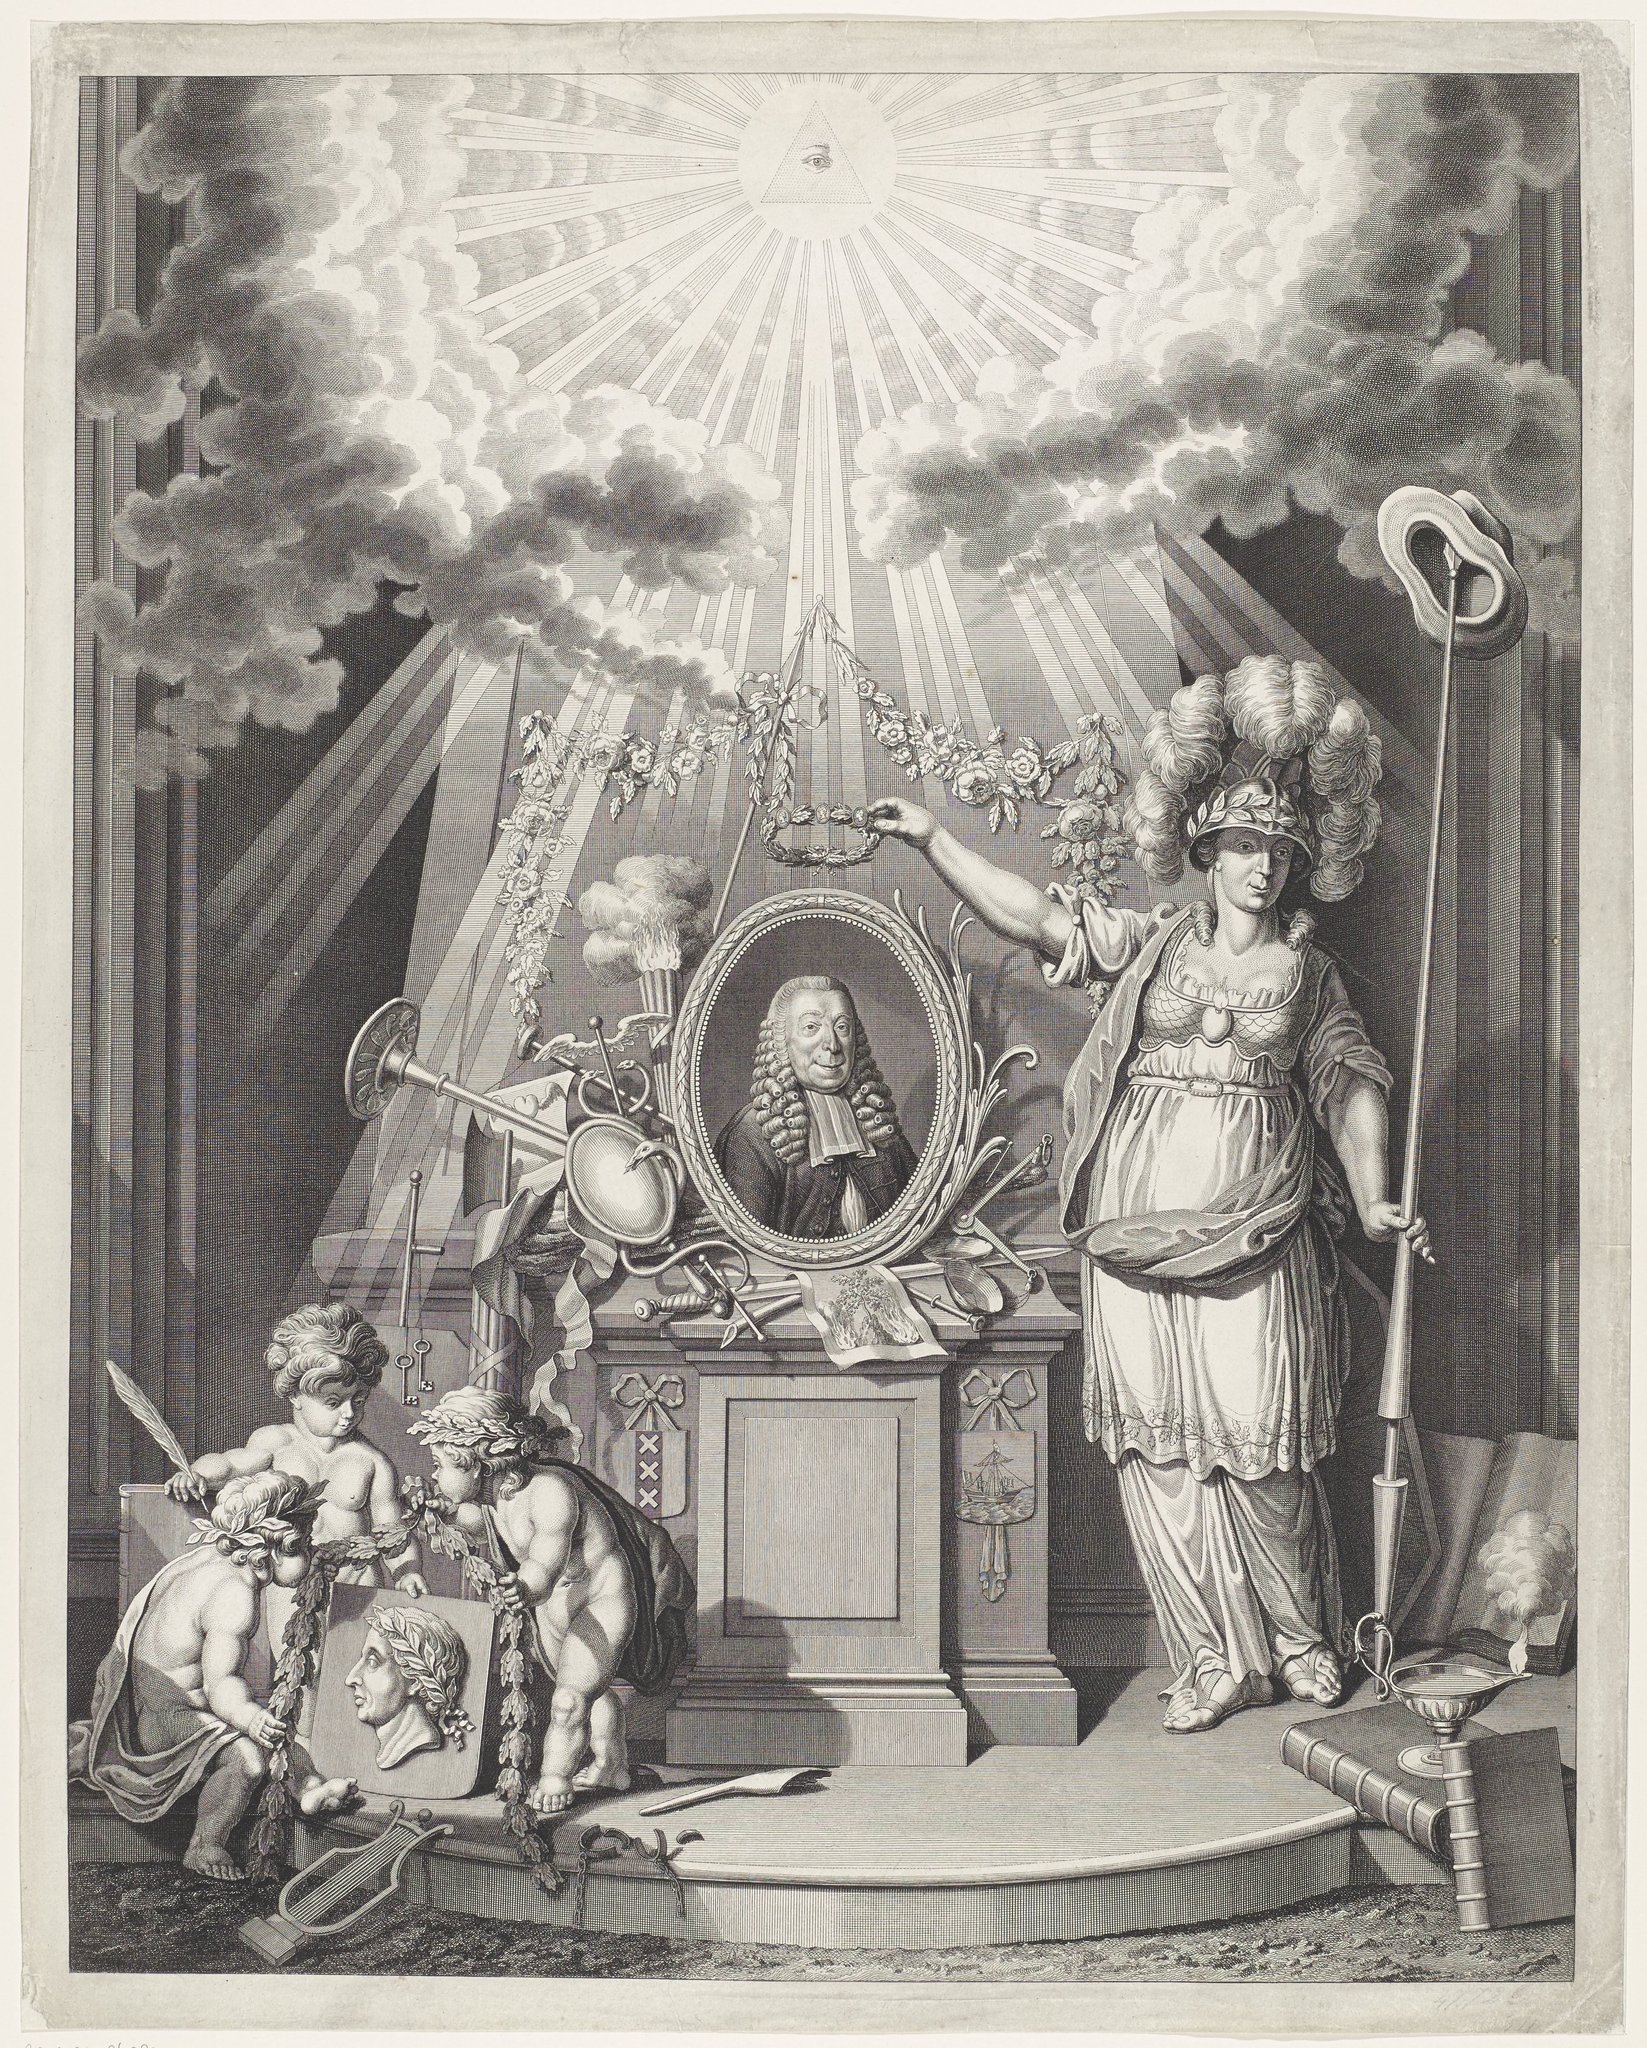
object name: print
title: Monument voor Hendrik Danielsz. Hooft, 1787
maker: noach van der meer (ii)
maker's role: draughtsman, print maker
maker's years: 1741-1822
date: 1788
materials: paper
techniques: engraving, etching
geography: northern netherlands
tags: mayor, hendrik danielsz. hooft, the all-seeing eye, triangle with eye ~ symbol of god the father, freedom, liberty; 'libertà' (ripa) (+ abstract concept represented by female figure), patriots (1780-1795)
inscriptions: collector's mark: Lugt 2228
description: Allegorisch monument voor de Amsterdamse burgemeester Hendrik Danielsz. Hooft, naar aanleiding van zijn verdediging van de patriotse belangen in de raad op 26 februari 1787. Portretmedaillon op voetstuk, bekroond met krans door de Vrijheid, links omhangen drie putti eikenloof om het wapen van Hooft. Bovenaan het stralende Alziende Oog.